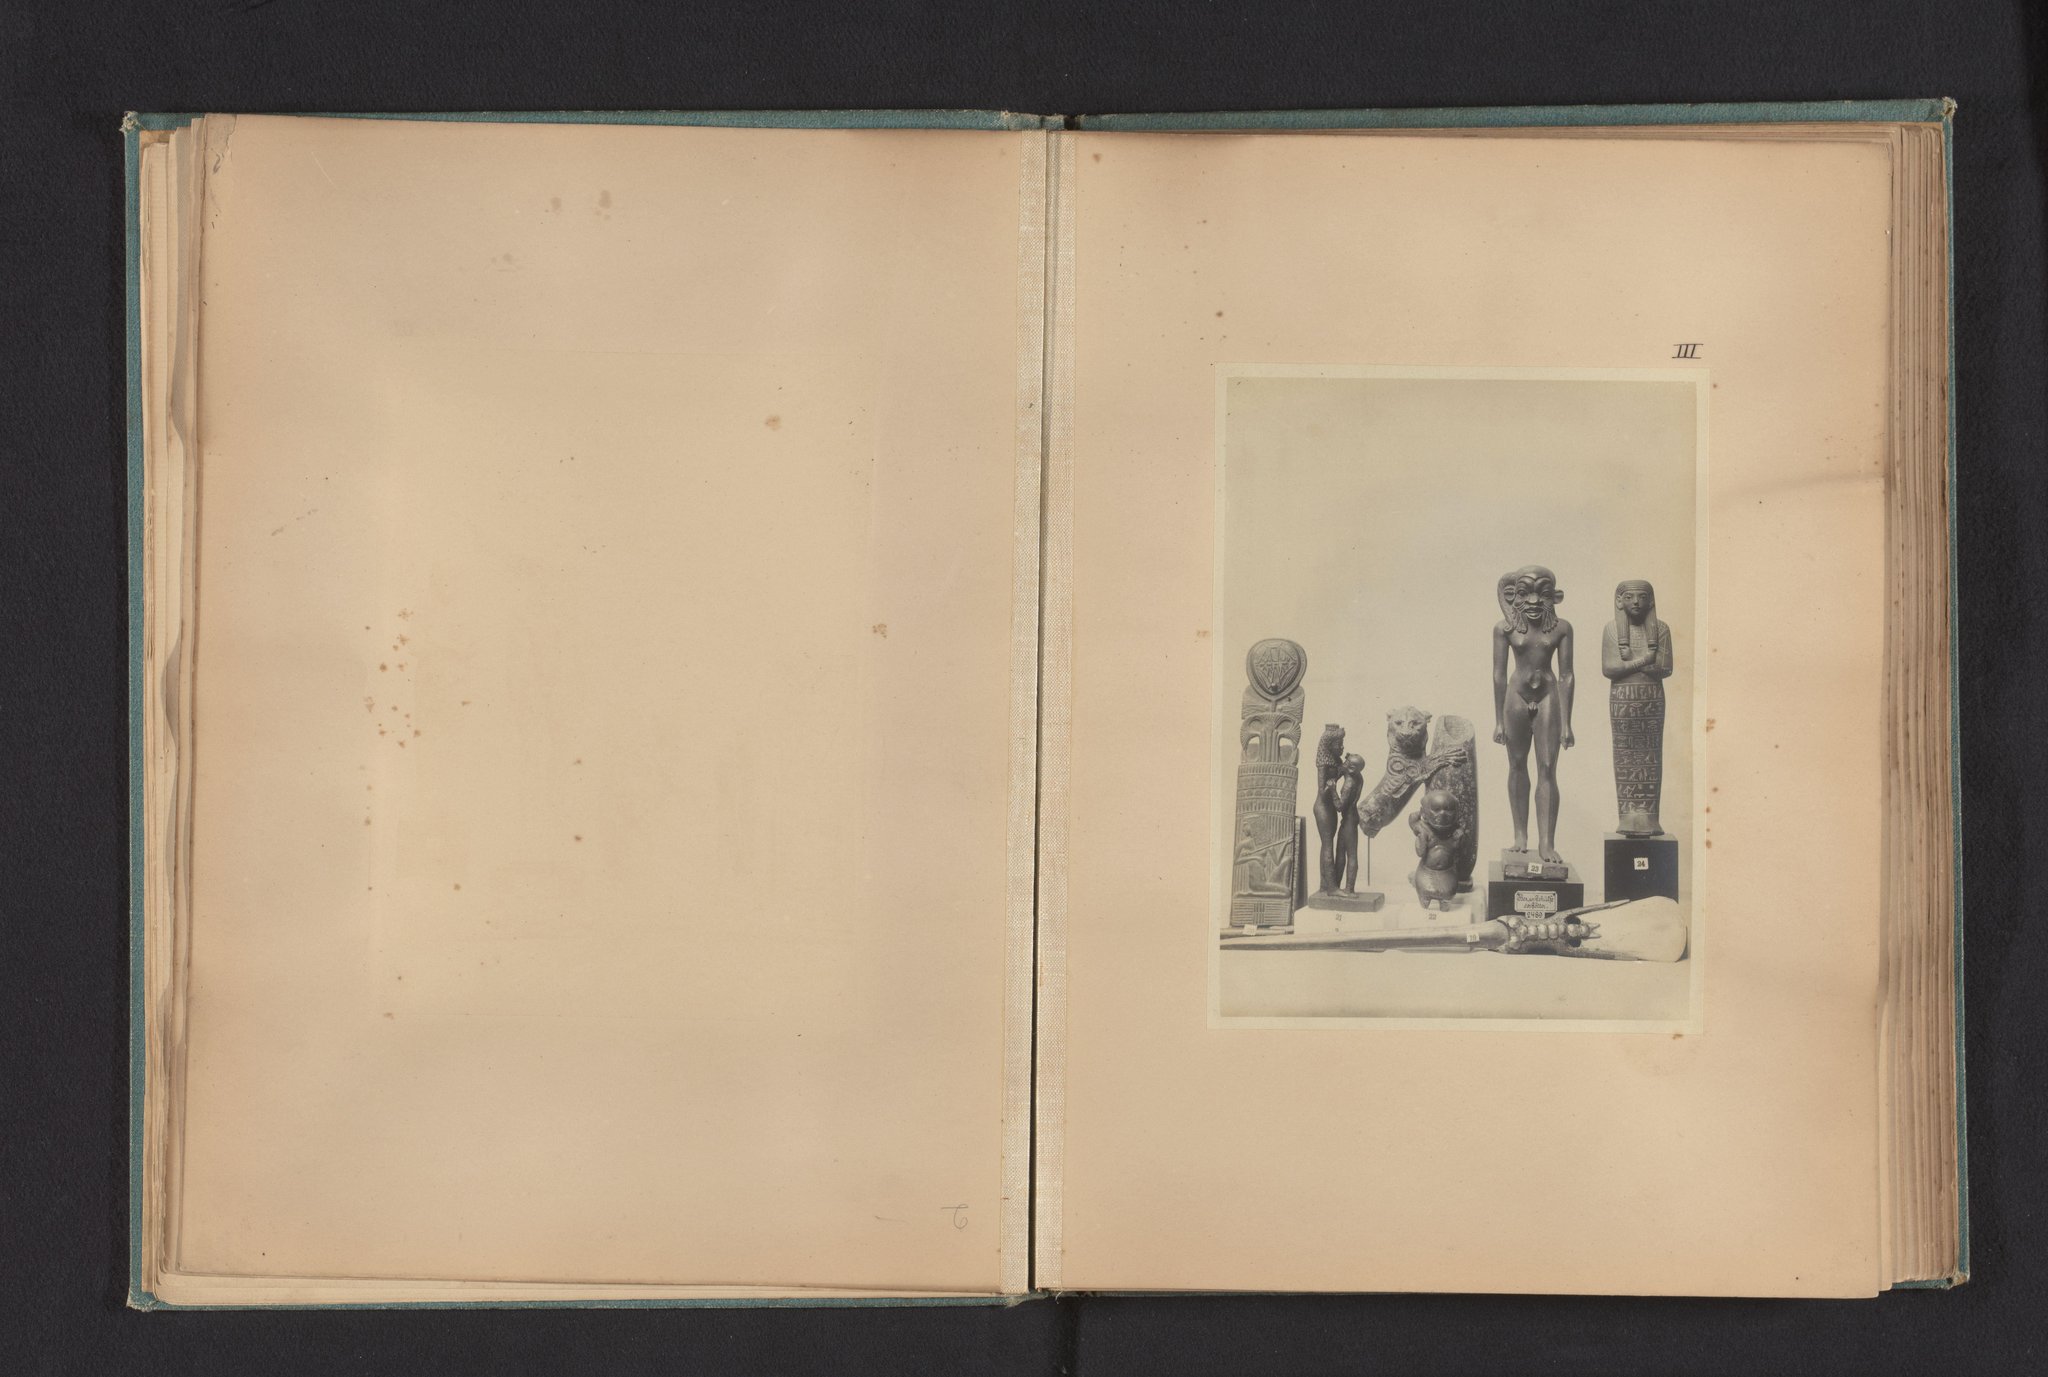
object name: page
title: Zeven Egyptische objecten, waaronder een bronzen sculptuur van Isis met Horus, een bronzen sculptuur van Harpocrates met het hoofd van Bes en een houten ushabti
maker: Anonymous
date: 1890-1895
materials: photographic support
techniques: gelatin silver print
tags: isis, the mother-goddess, horus, son of osiris and isis, representations ~ egyptian gods, demi-gods, heroes, etc. (harpocrates), representations ~ egyptian gods, demi-gods, heroes, etc. (bes), sculpture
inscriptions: number: ‘III’